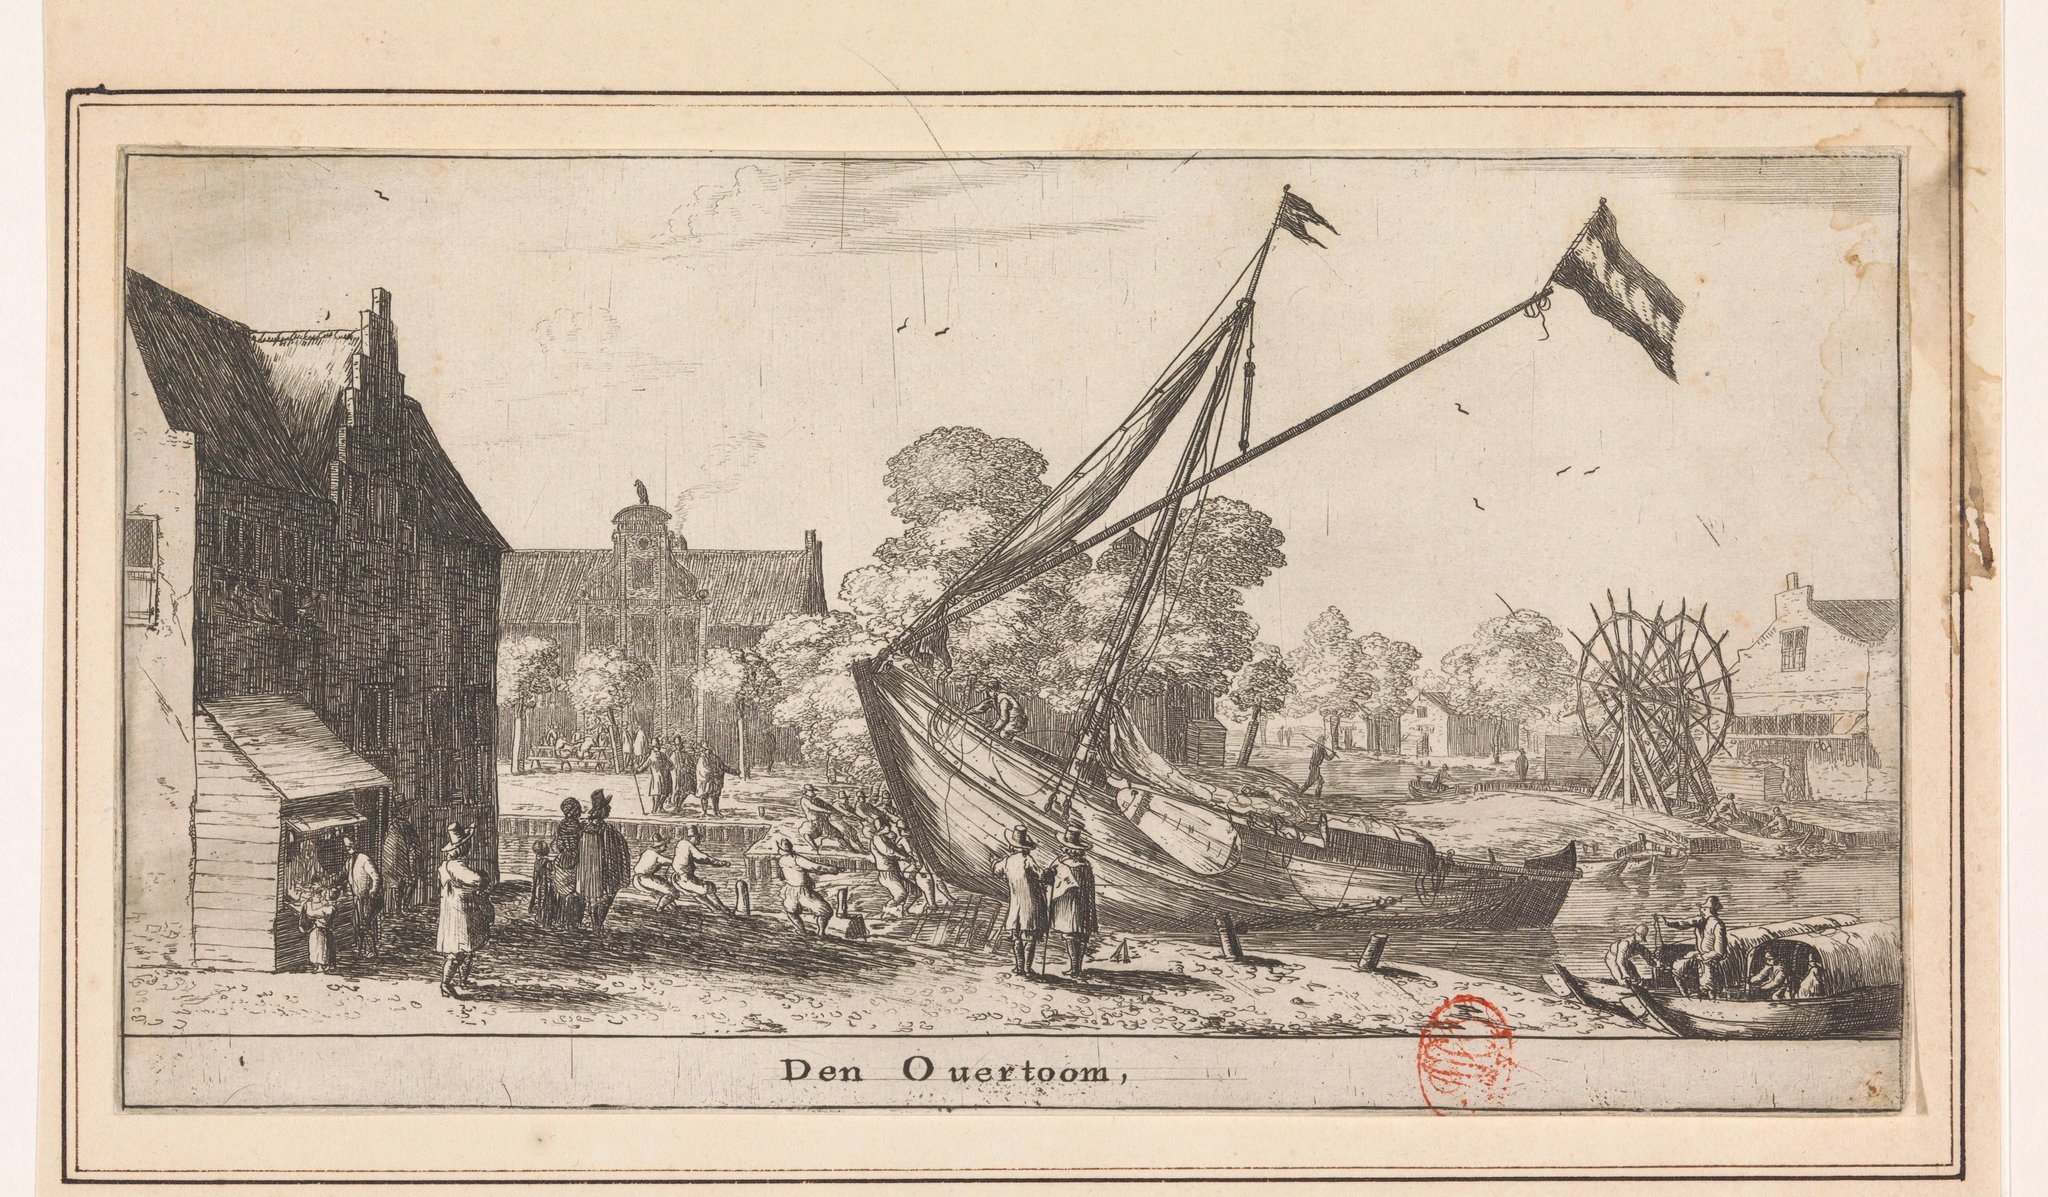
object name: print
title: Gezicht op de Overtoom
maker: reinier nooms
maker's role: draughtsman, painter, print maker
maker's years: 1623-1664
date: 1652-1654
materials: paper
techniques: drypoint, etching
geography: netherlands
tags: rolling bridge (dutch: 'overtoom')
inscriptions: collector's mark: Lugt 195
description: Een schip wordt over de overtoom getrokken, van de Kostverlorenvaart naar de Schinkel. Links vooraan het Leidse veerhuis, bij het begin van de Amstelveenseweg, daarachter de herberg De Valk aan de Sloterkade. Rechtsonder genummerd: 6.